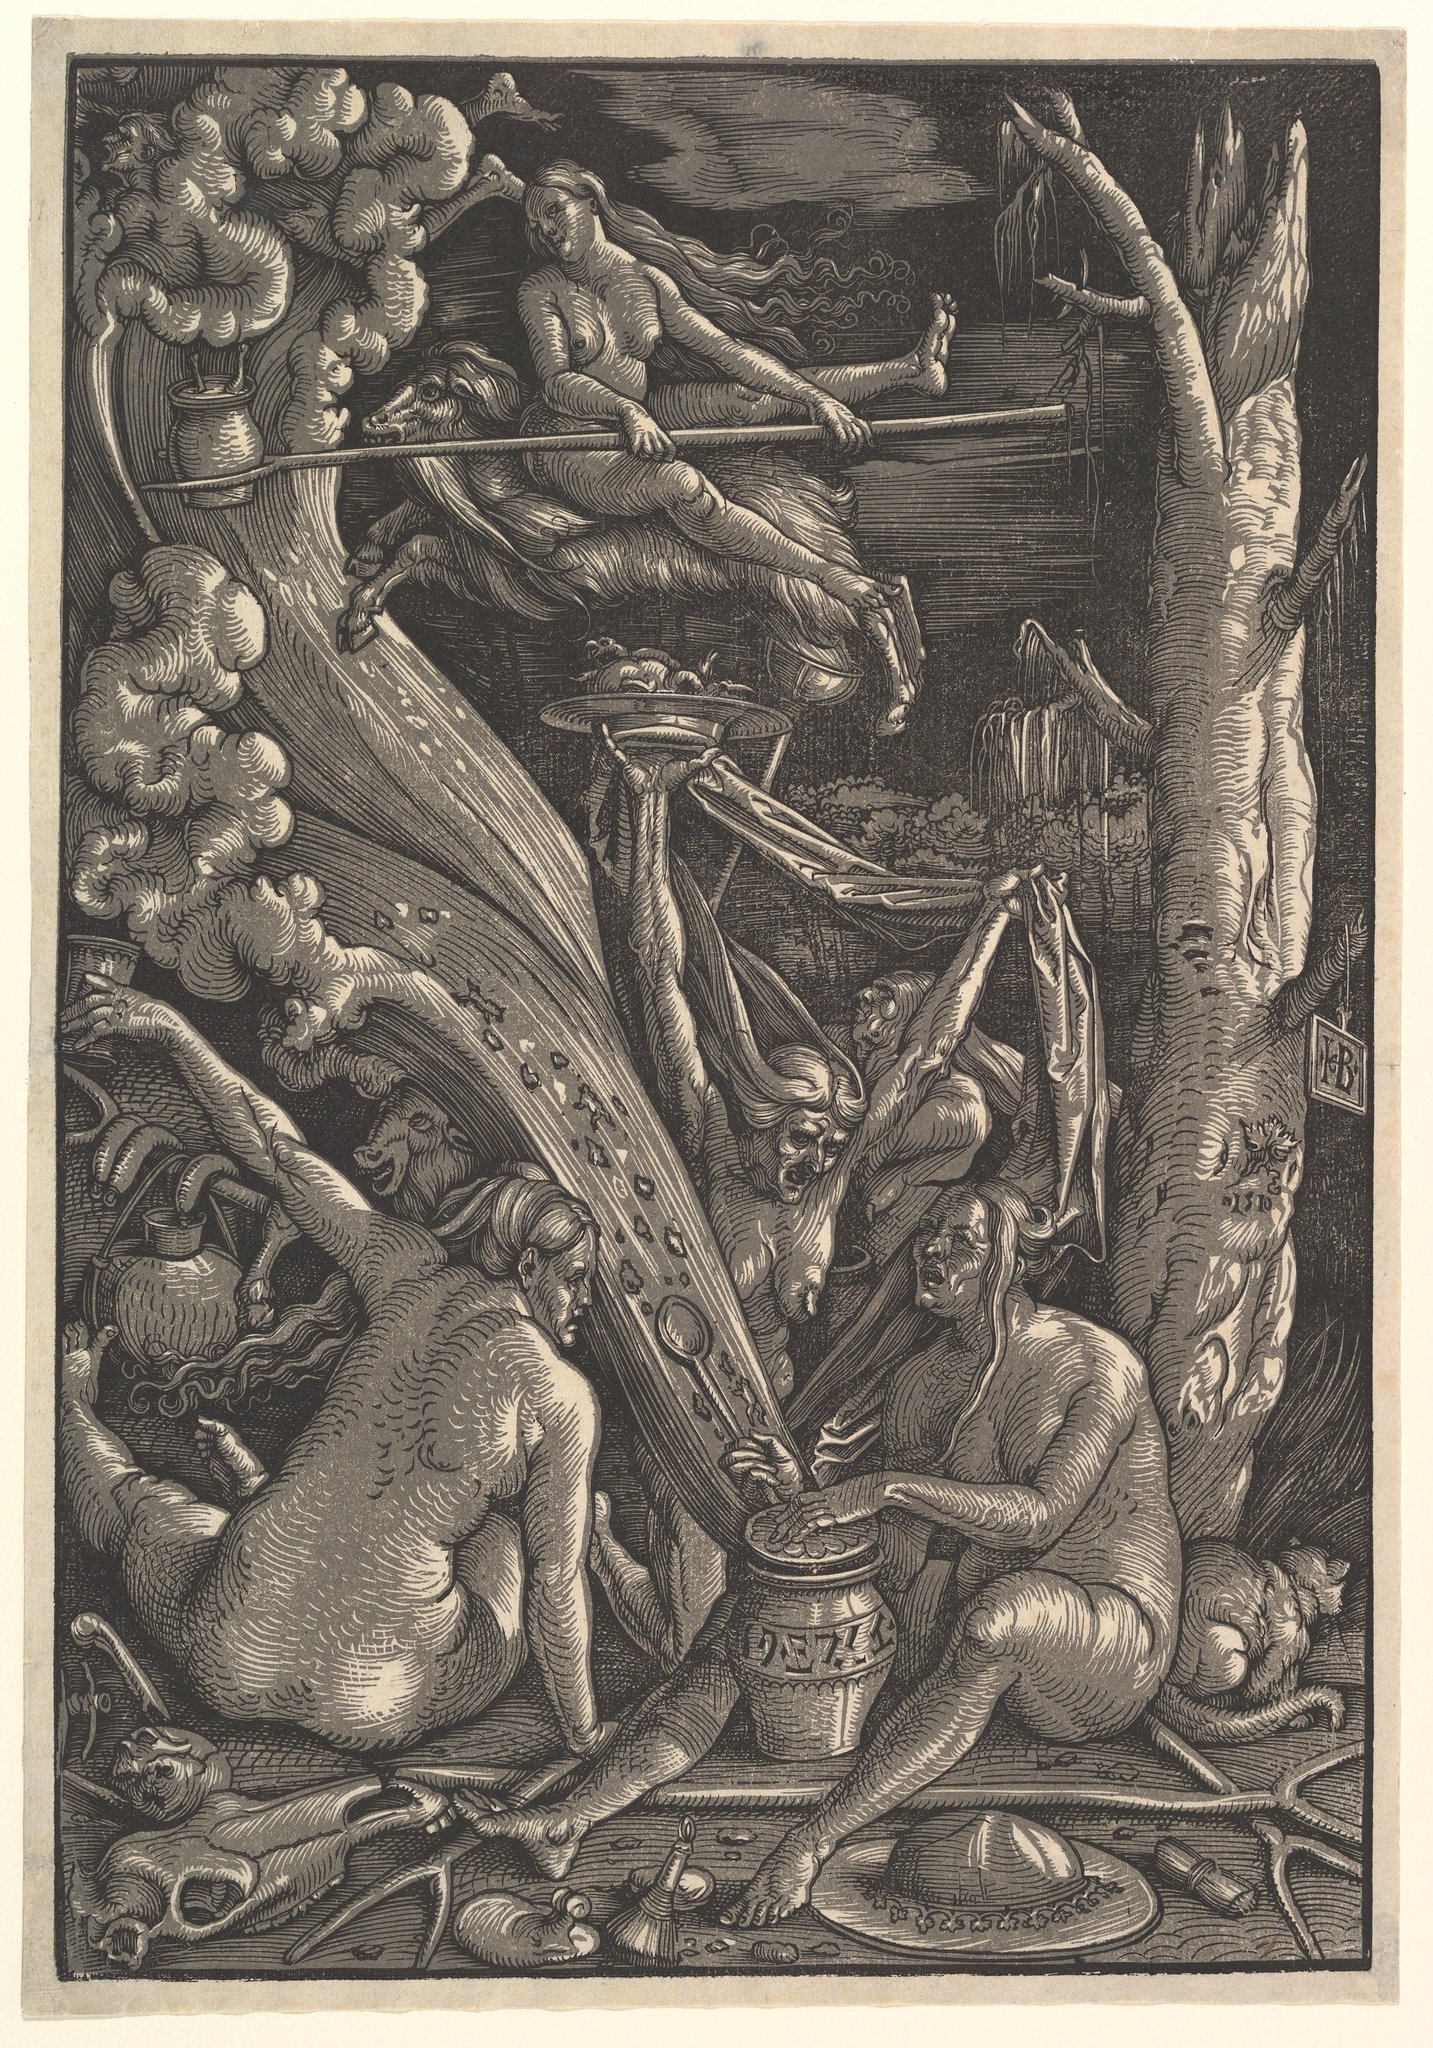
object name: print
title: The Witches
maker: hans baldung (called hans baldung grien)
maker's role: artist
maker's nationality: german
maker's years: 1484-1545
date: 1510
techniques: woodcut, printing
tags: animals,female nudes,witches